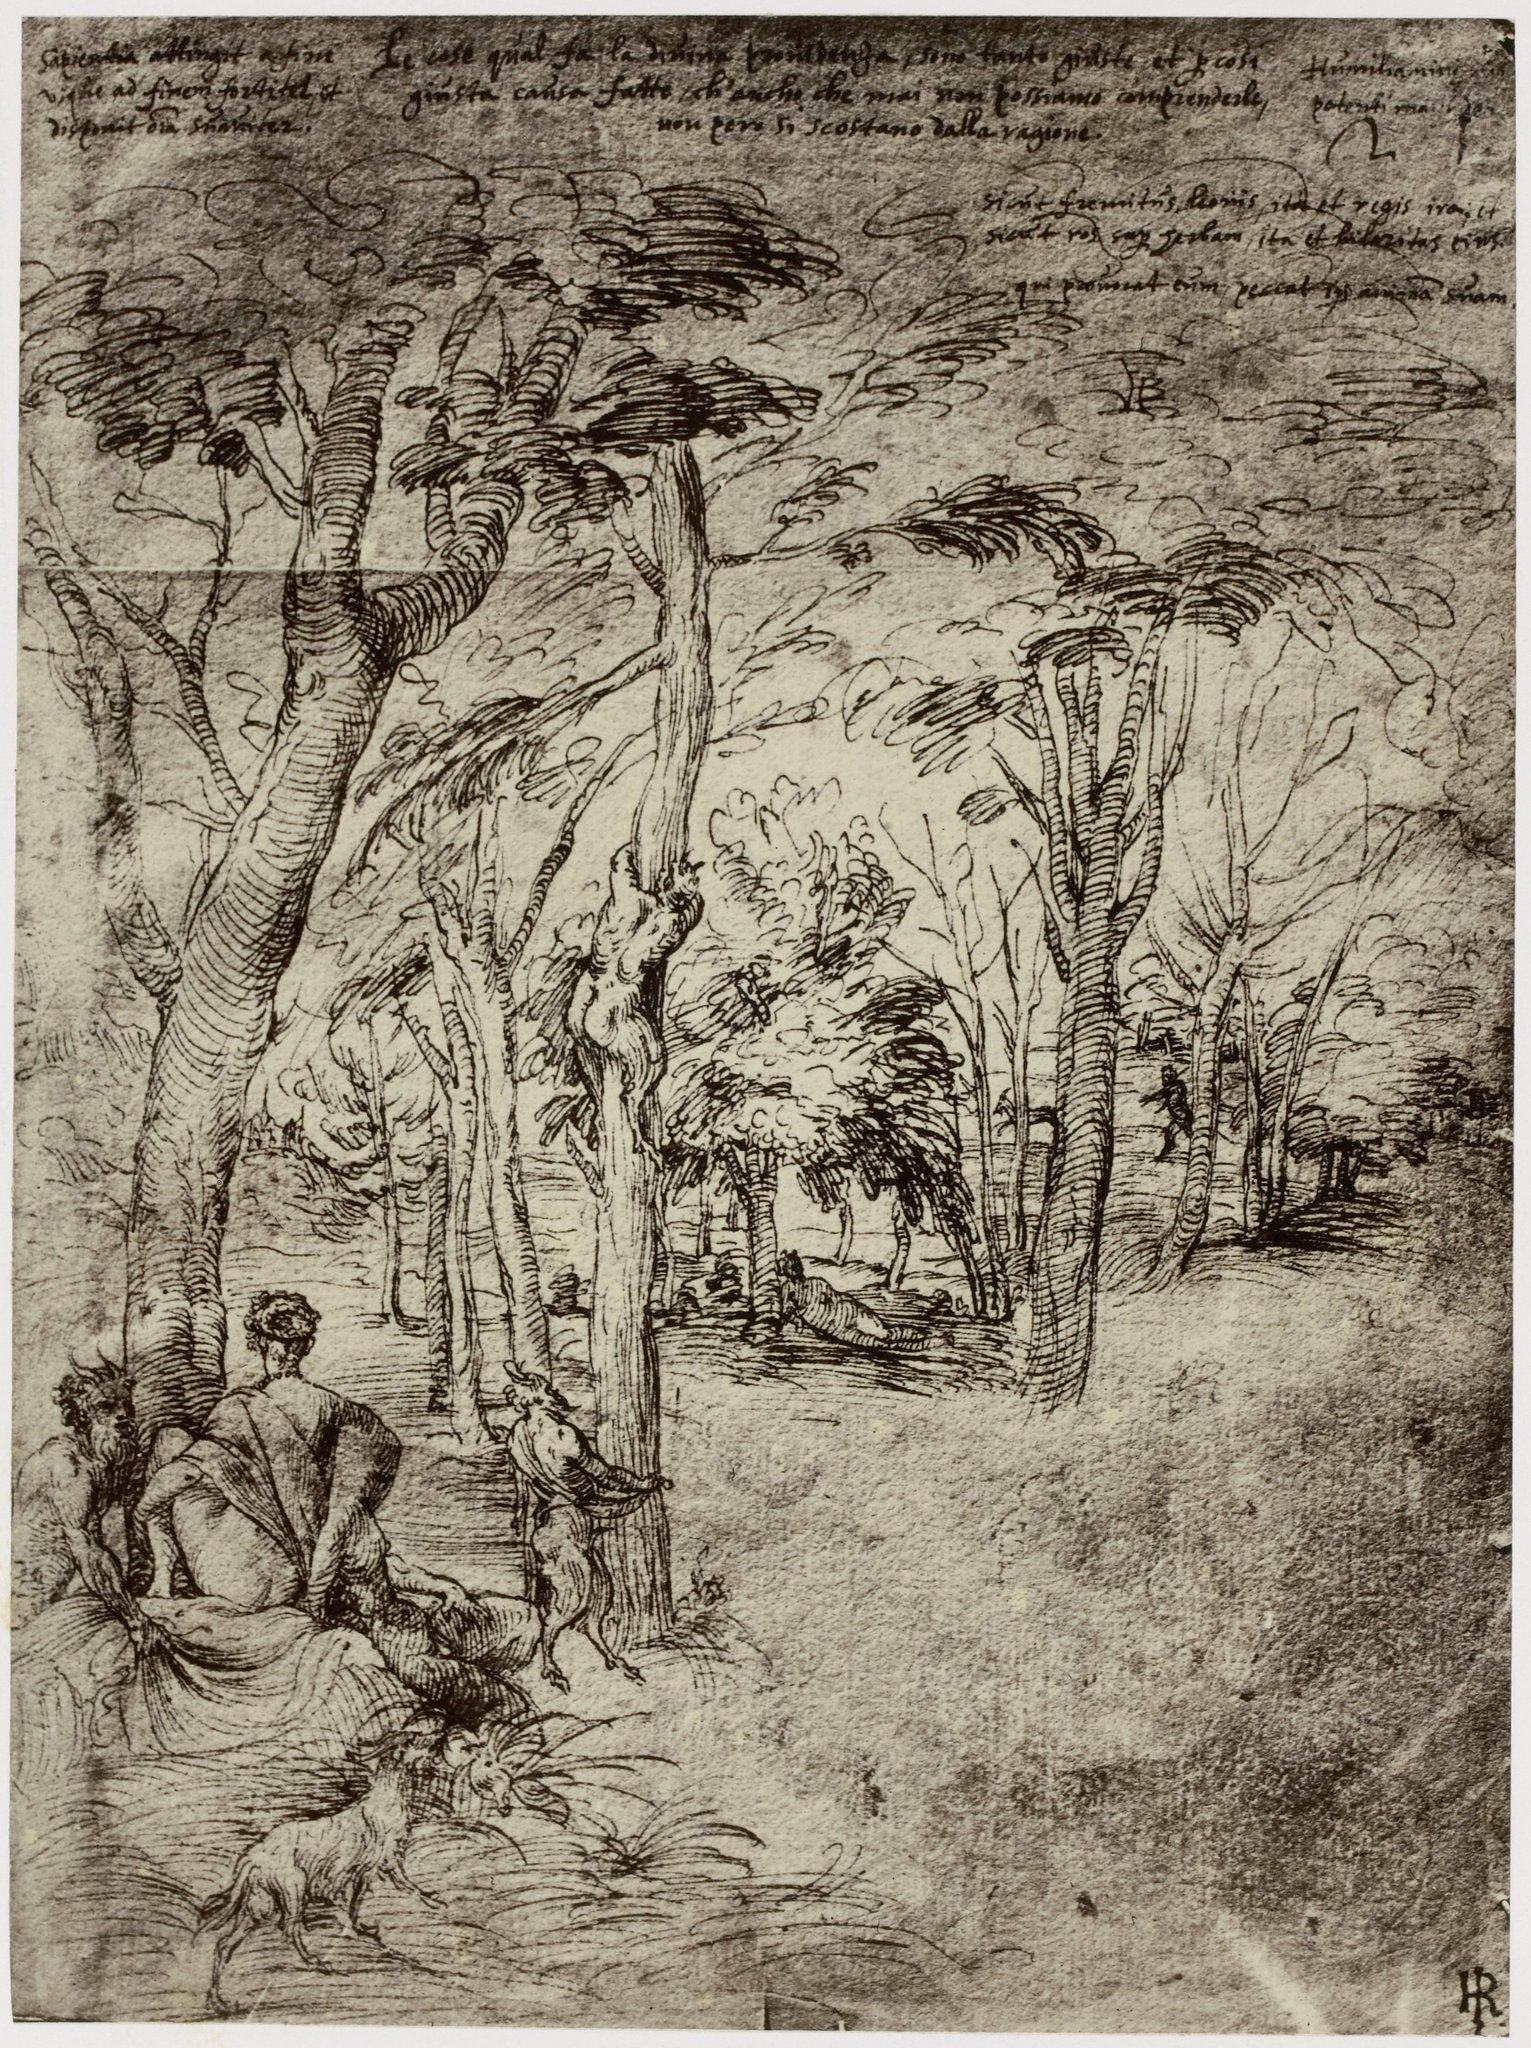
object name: photograph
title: Titiaan, Design for a Picture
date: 1855-1858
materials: cardboard, paper, photographic support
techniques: albumen print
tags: drawing, sketch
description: Fotoreproductie van tekening in 'The Reveley Collection of Drawings at Brynygwin', afb. 11.